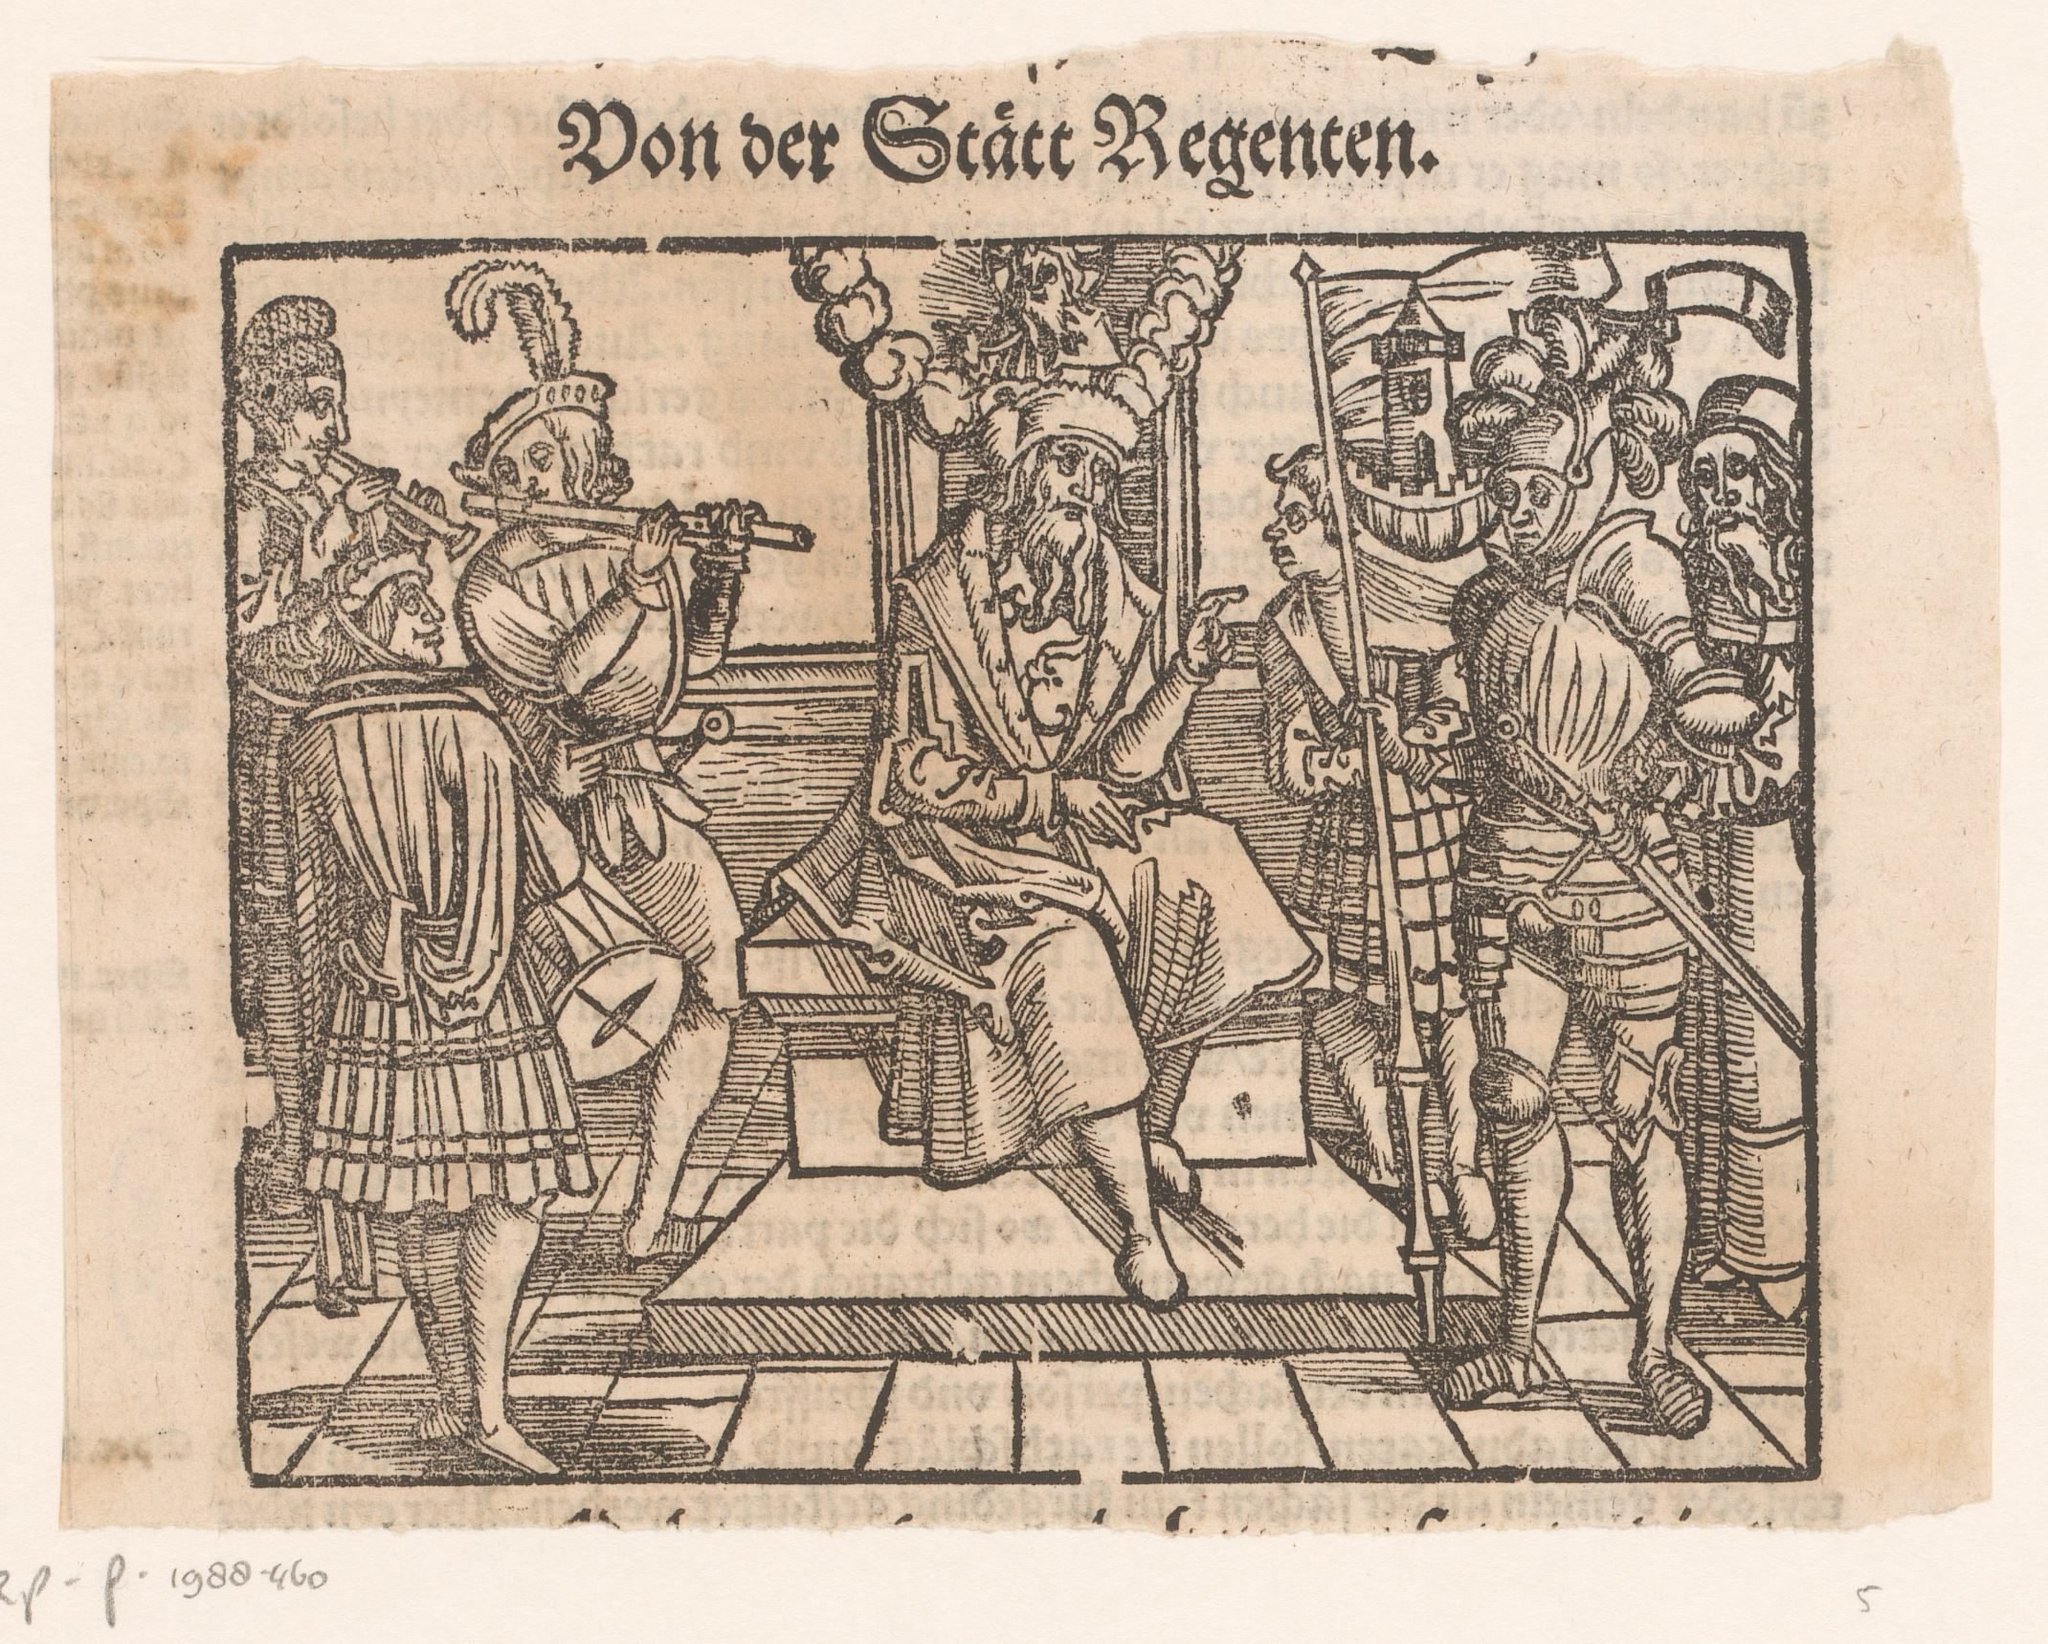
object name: book illustration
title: Rechtspraak aangaande regenten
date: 1518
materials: paper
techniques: woodcut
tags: court session (court of justice), regent, substitute ruler; viceroy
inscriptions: collector's mark: Lugt 2228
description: Prent voor het eerst gebruikt in: Tengler, Ulrich. Neü Layenspiegel. Straatsburg: Matthias Hupfuff, 1518.